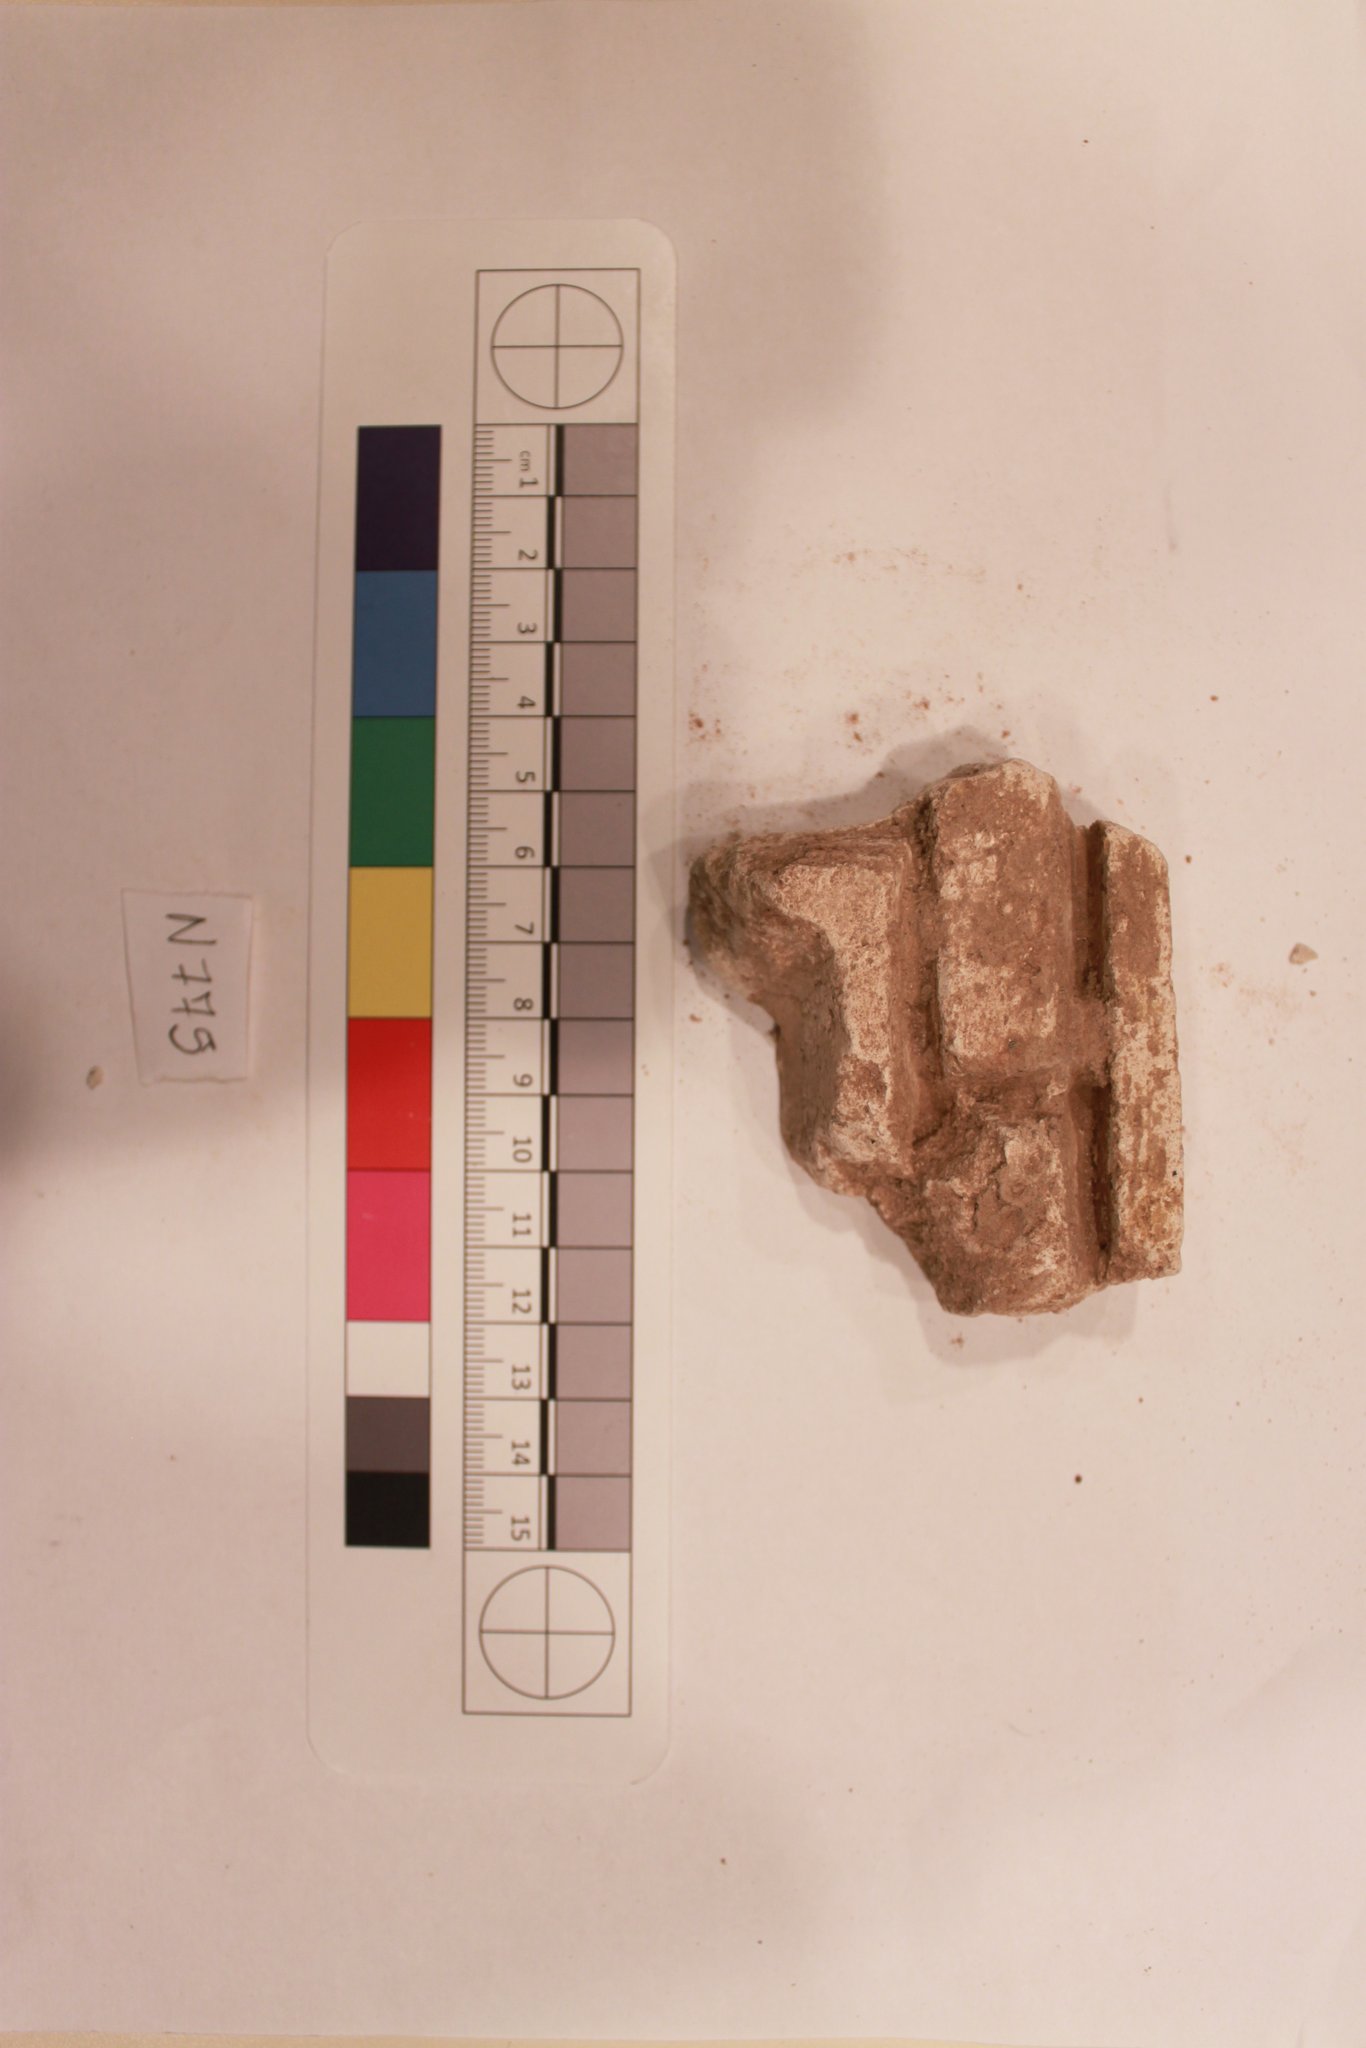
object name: fragment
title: Stucco Fragment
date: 701-1200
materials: plaster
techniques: carving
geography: iran